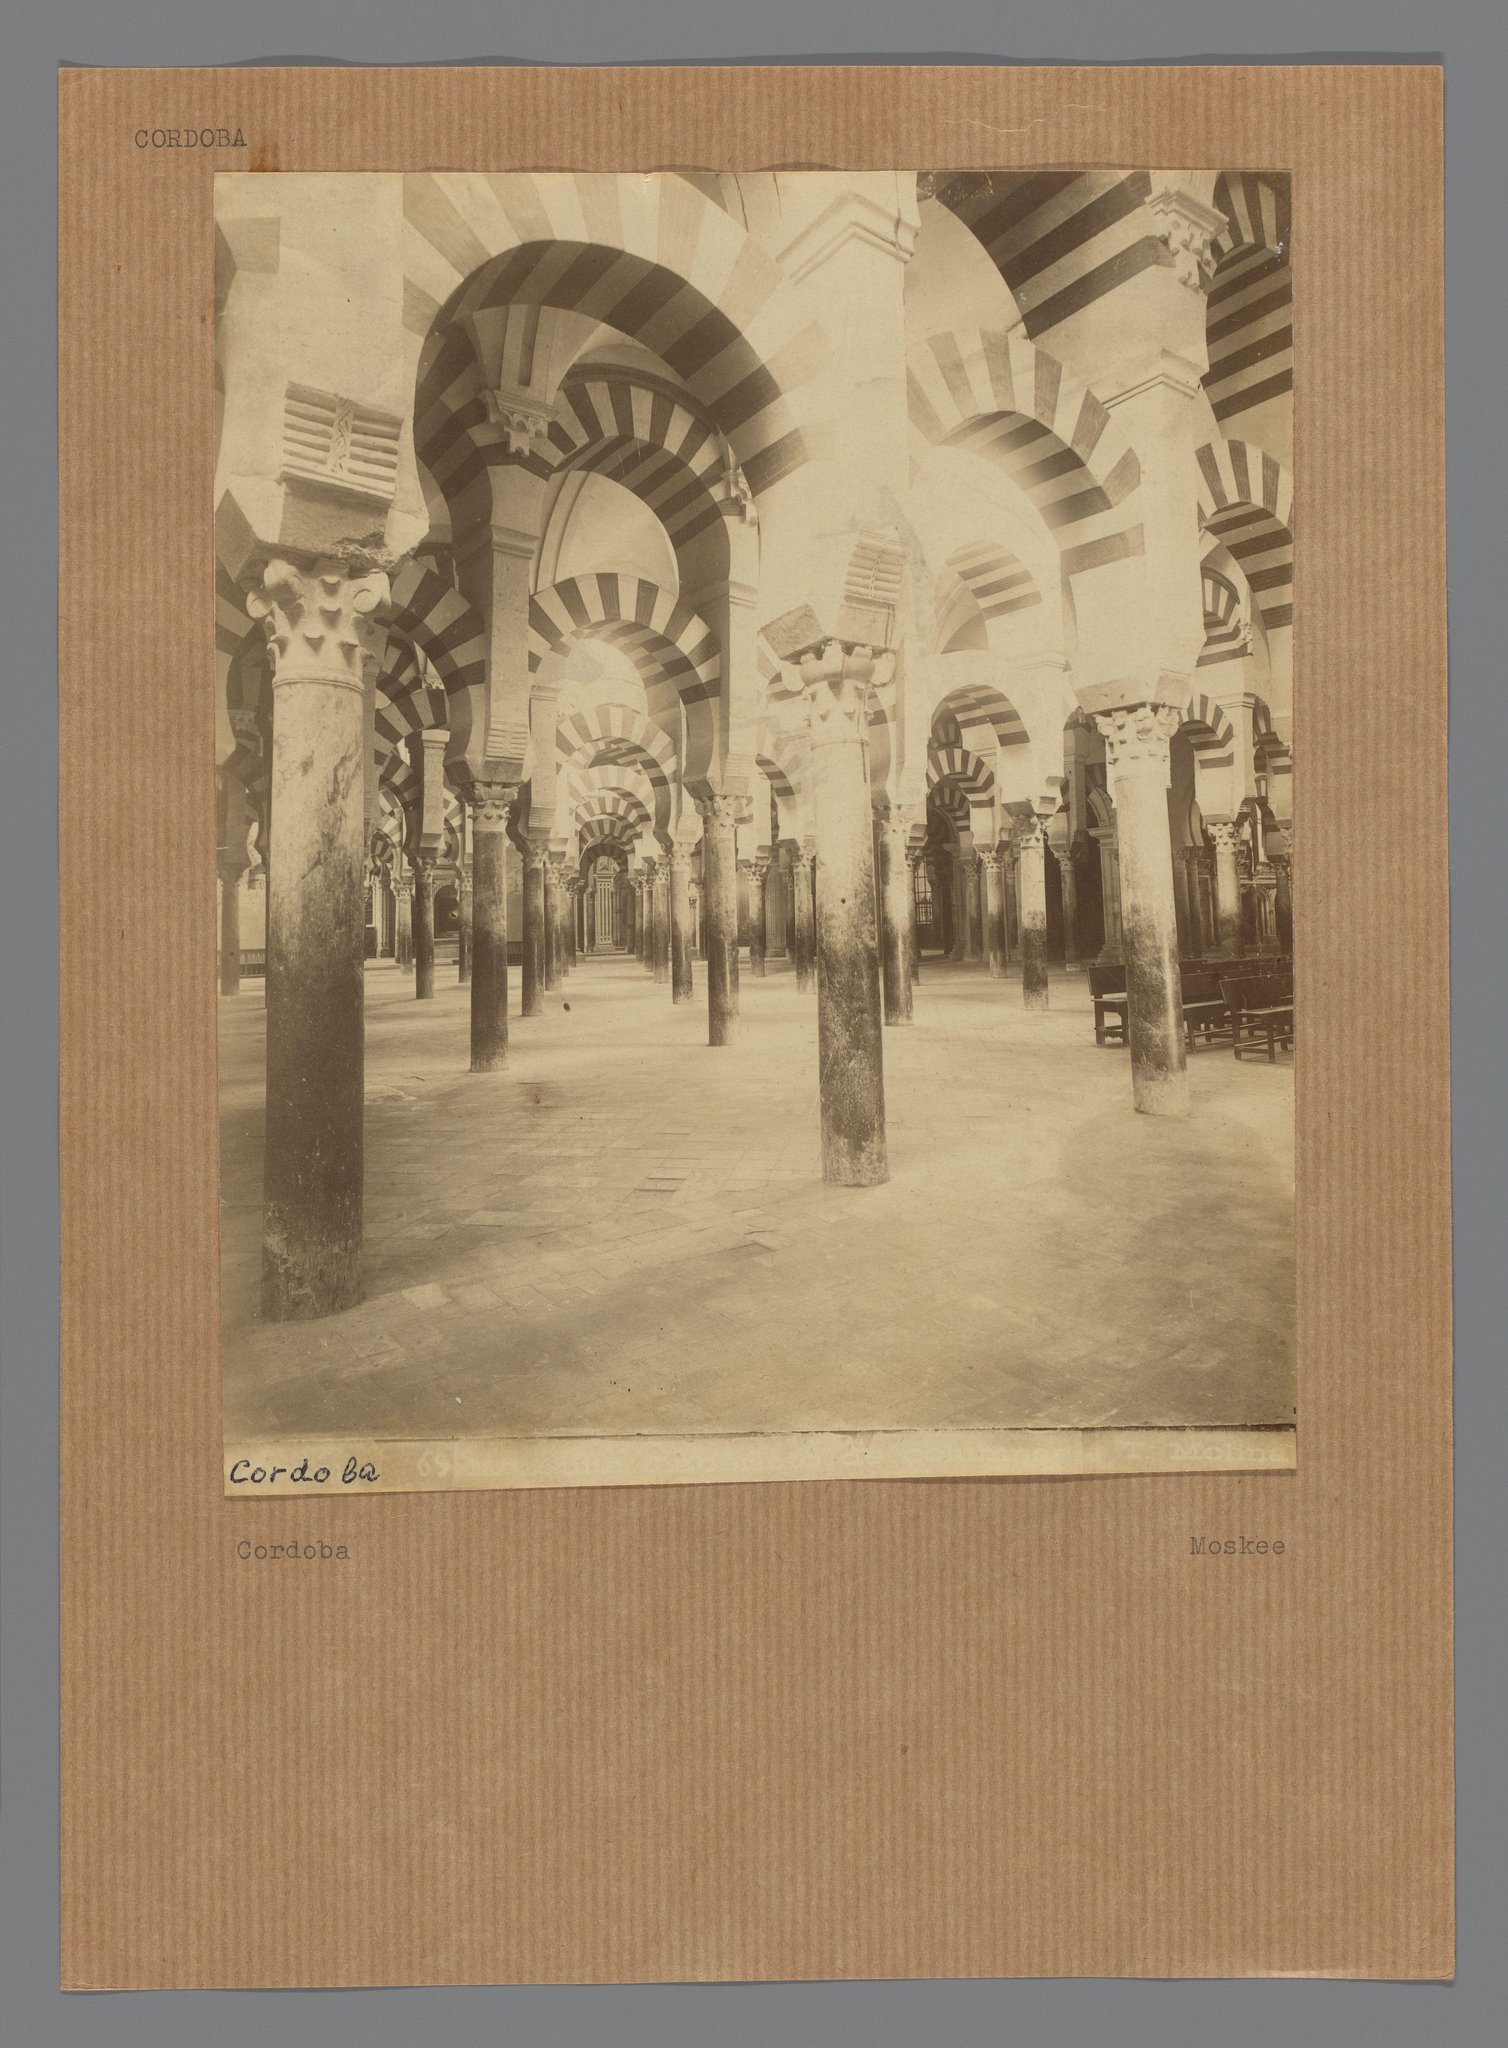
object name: photograph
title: Moskee Cordoba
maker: tomas molina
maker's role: fotograaf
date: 1850-1899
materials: paper, photographic support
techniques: albumen print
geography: spain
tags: mezquita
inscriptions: stamp: ‘UNIVERSITEIT VAN AMSTERDAM / KUNST / HISTORISCH / INSTITUUT’, inscription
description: Foto uit de studiecollectie van het Kunsthistorisch Instituut van de Universiteit van Amsterdam.